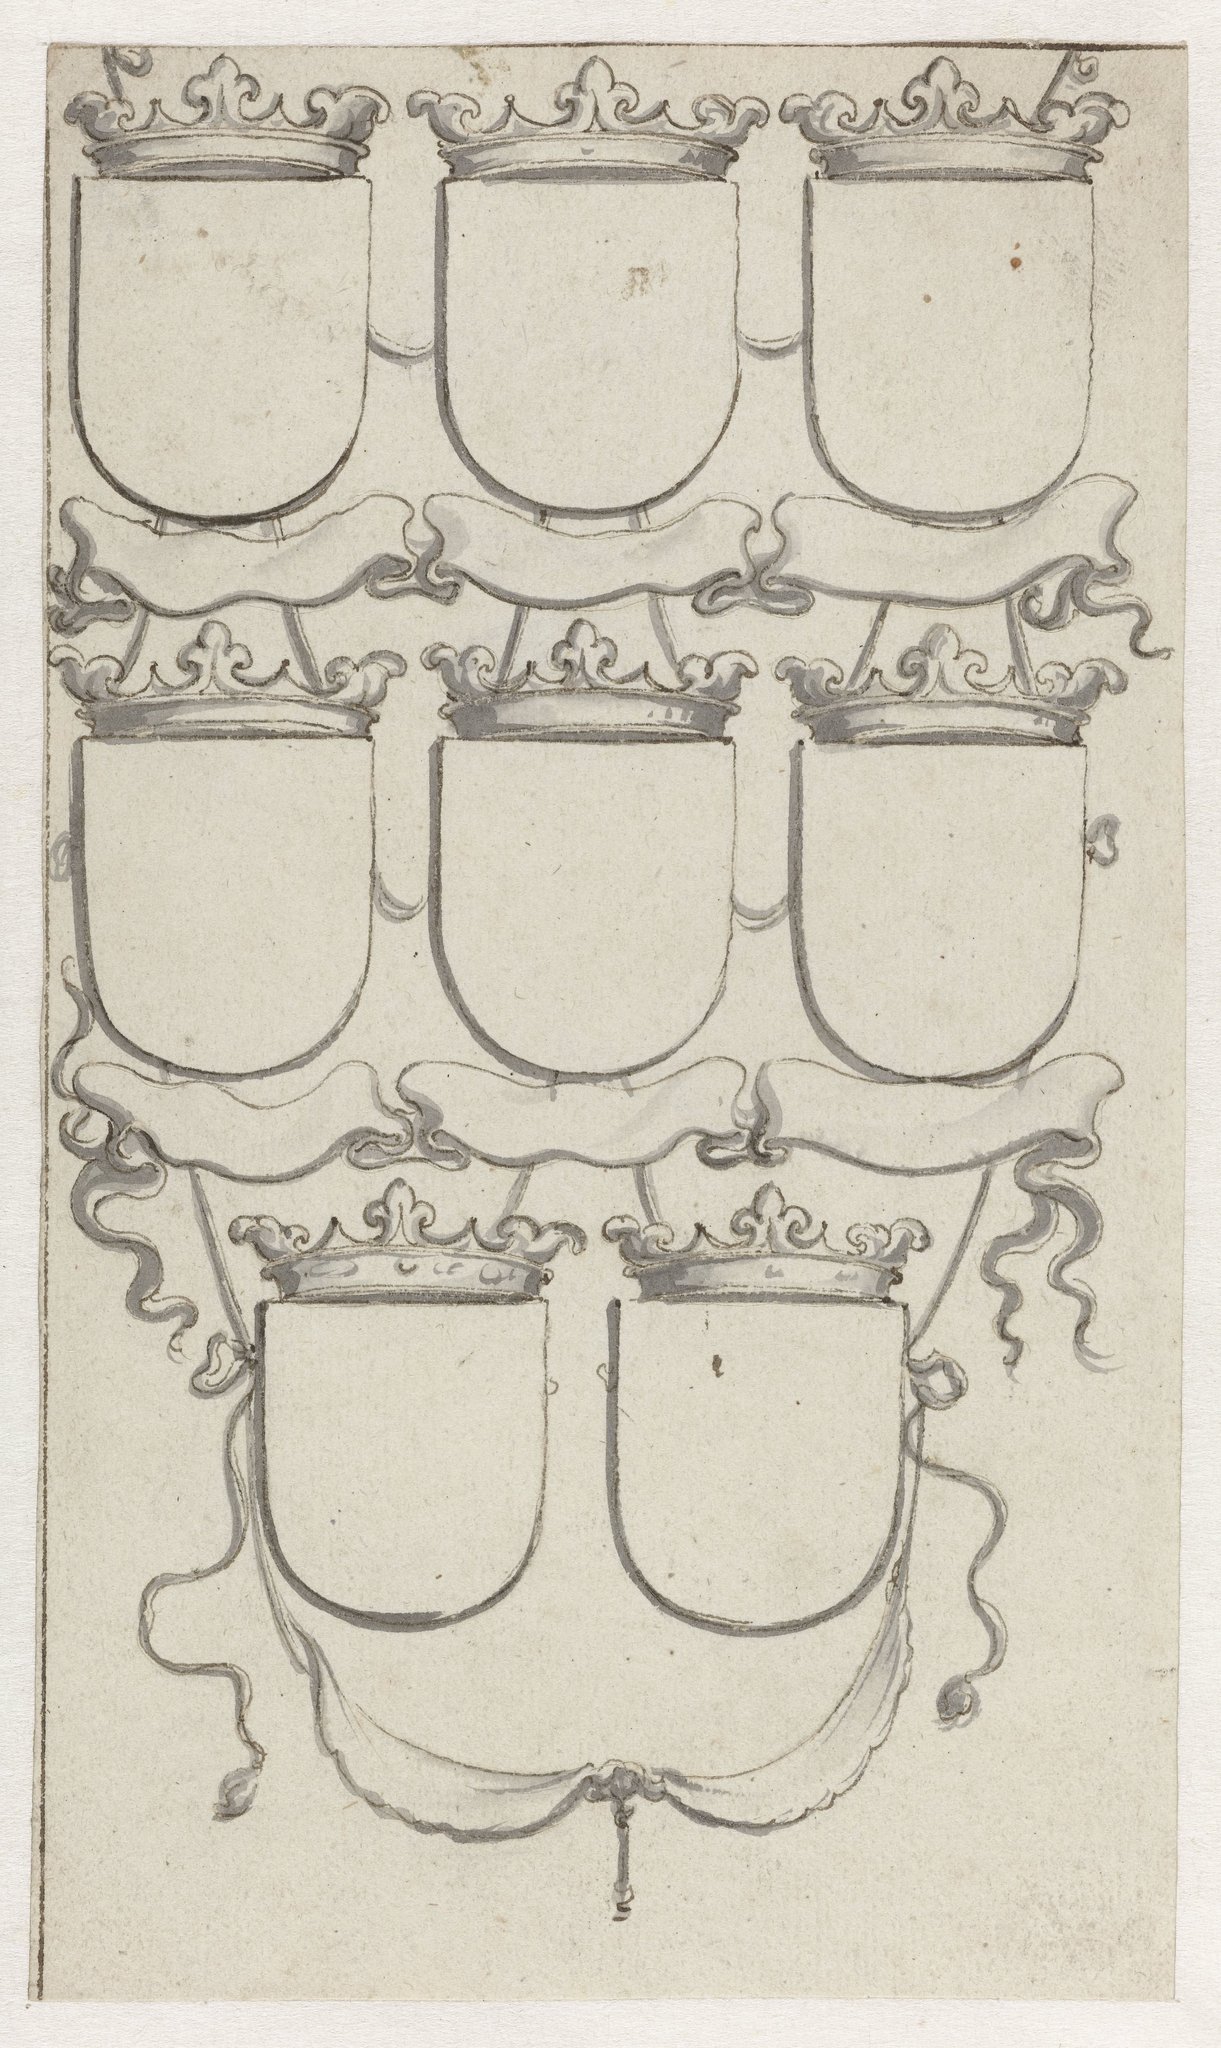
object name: design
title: Acht blanco wapenschilden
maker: pieter jansz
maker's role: draughtsman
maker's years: 1602-1672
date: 1630-1672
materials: ink, paper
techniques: brush, pen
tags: armorial bearing, heraldry